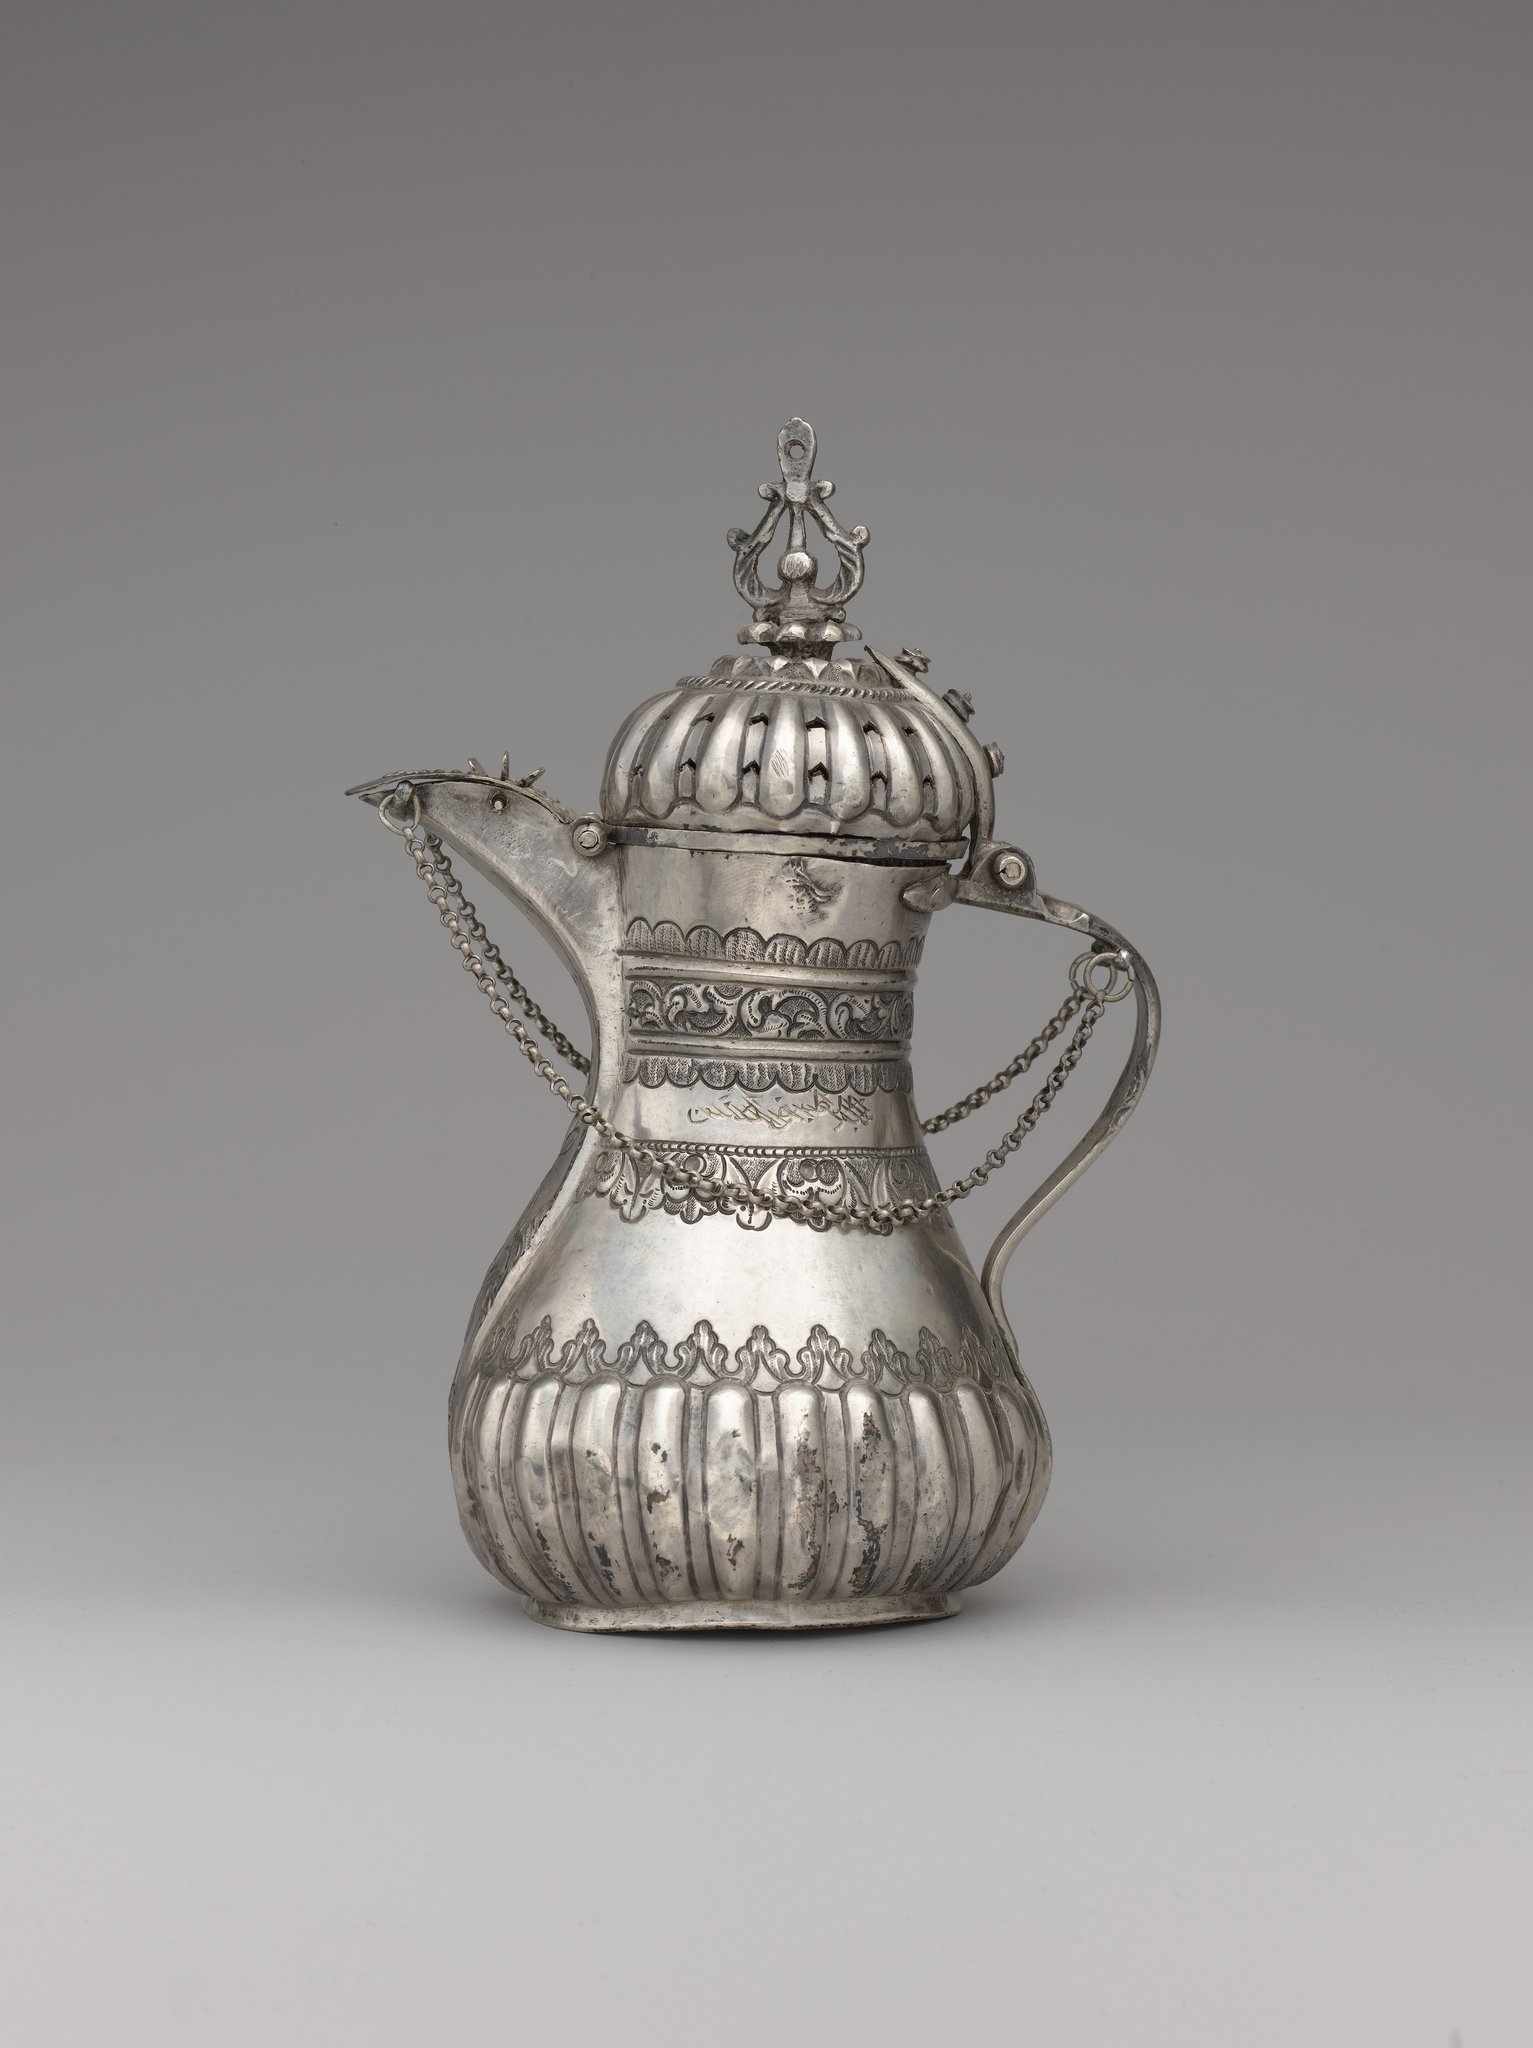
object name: coffee pot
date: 1809-1860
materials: gilt, silver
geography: turkey